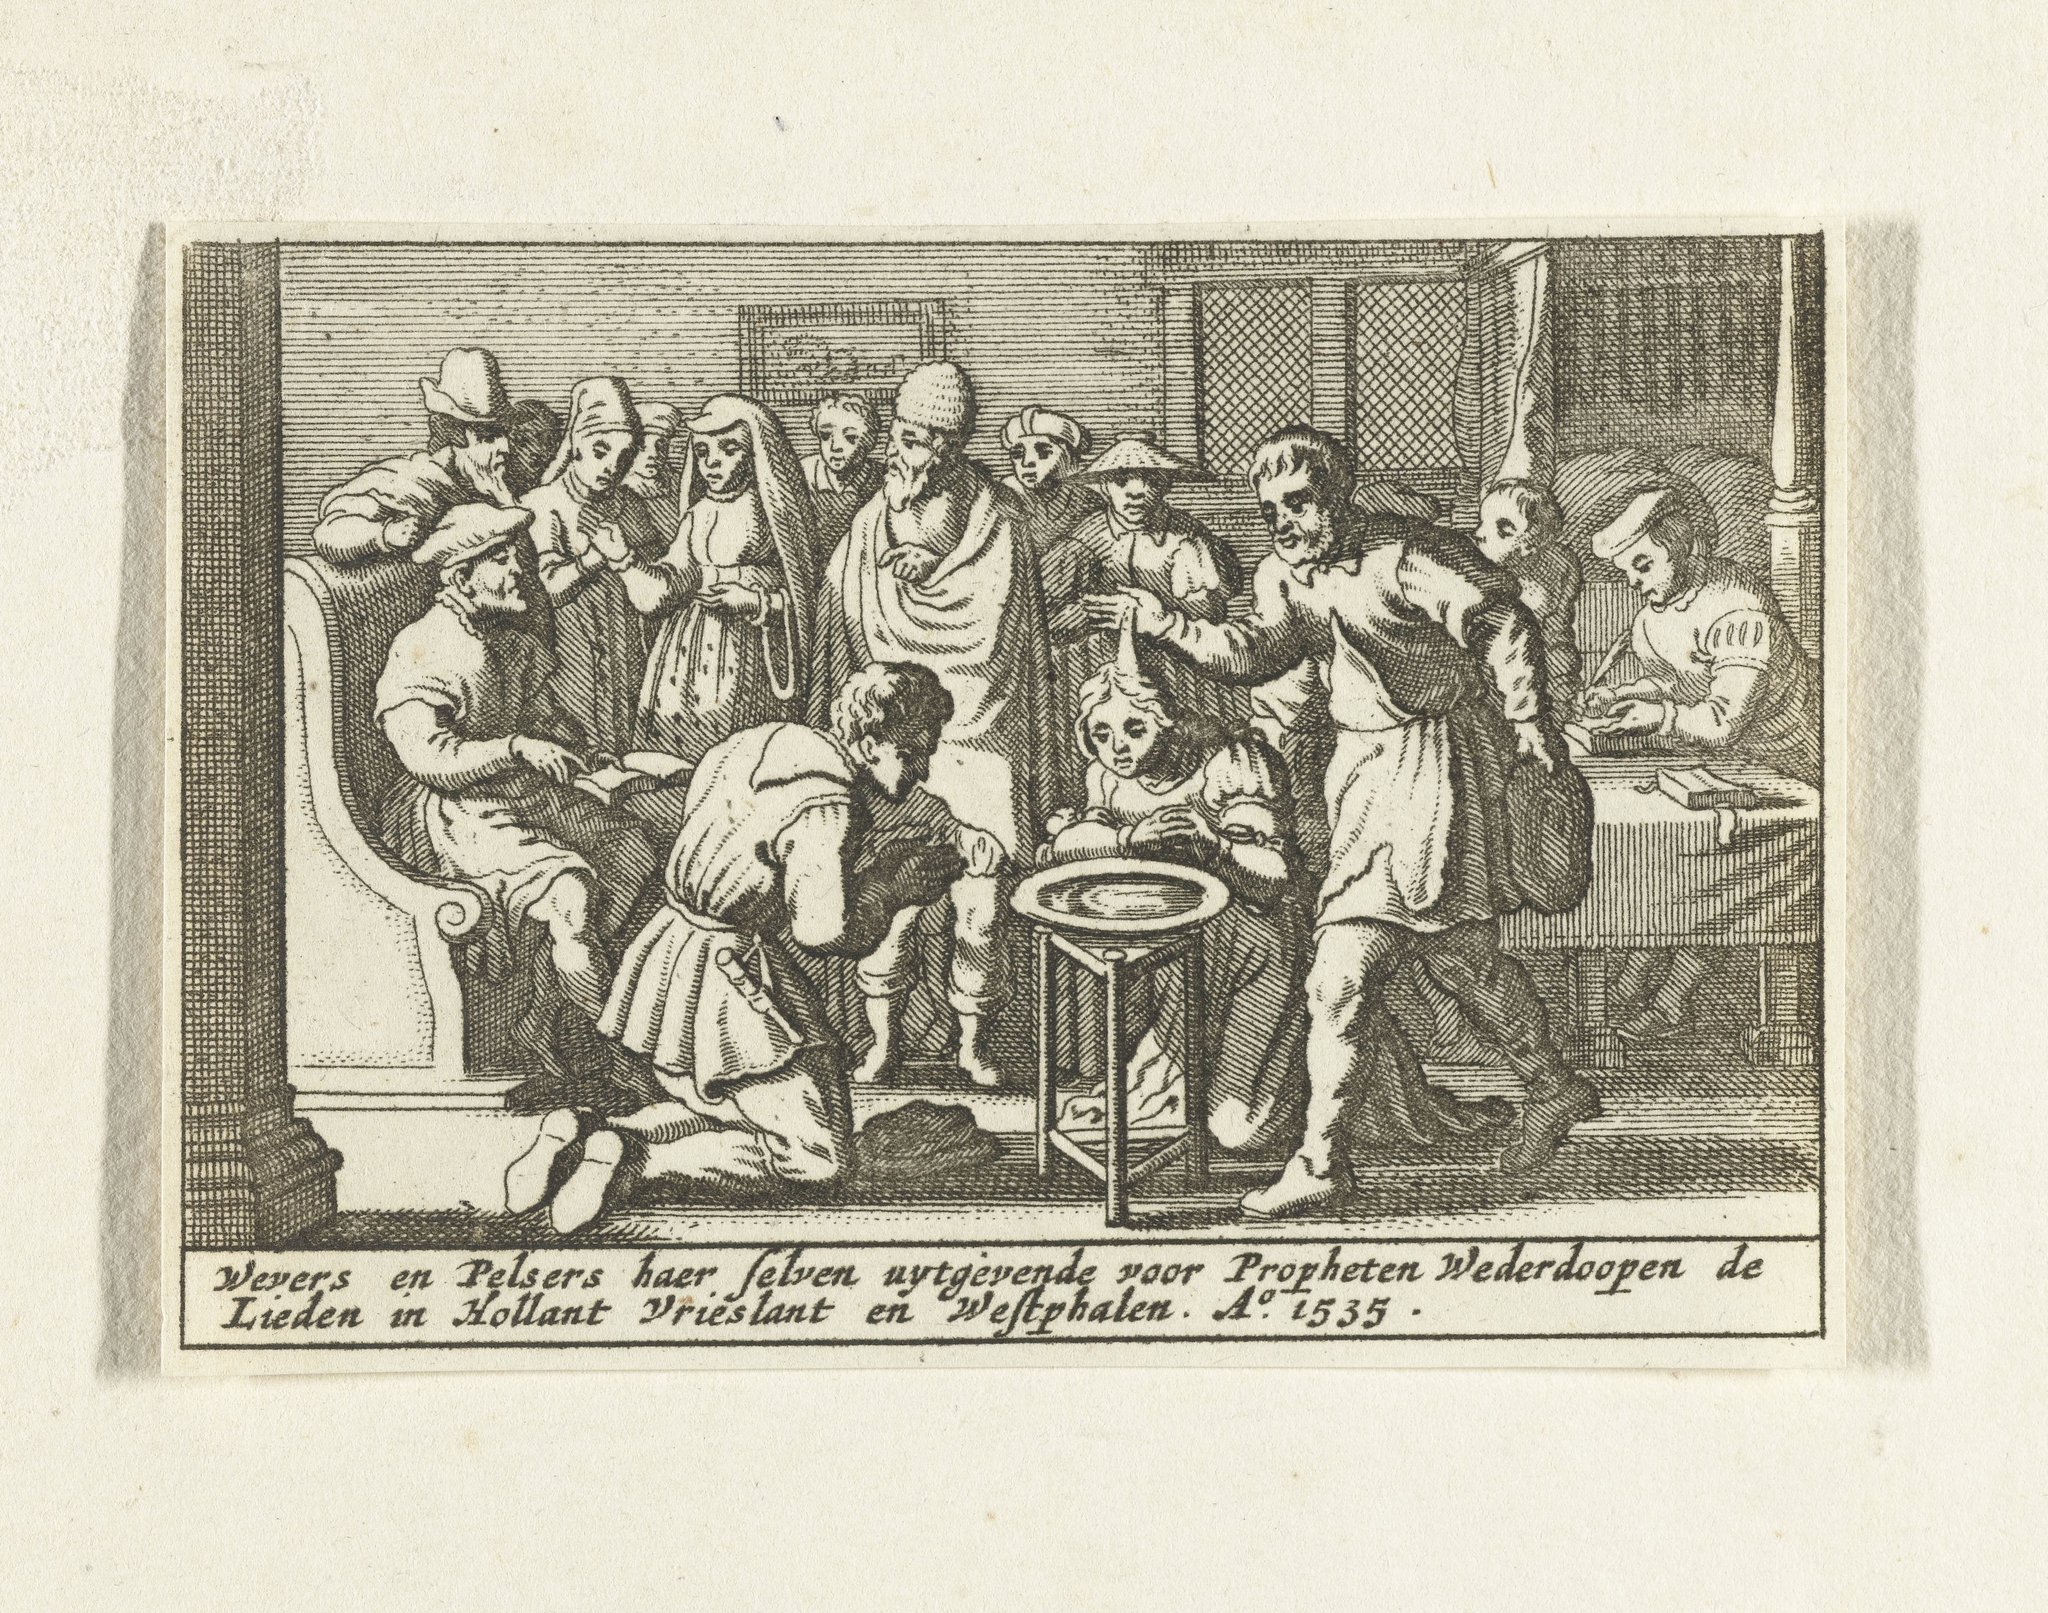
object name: print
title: Doop der wederdopers, 1535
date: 1629-1652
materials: paper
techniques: etching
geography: northern netherlands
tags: baptism ~ protestant service, amsterdam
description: Deze prenten zijn gebaseerd op de oorspronkelijke anonieme gravures in de eerste uitgave L. Hortensius, Van den oproer der weder-dooperen, 1614. Alle 8 prenten op op één blad geplakt. Naar het verloren gegane schilderij van Barend Dircksz. in het oude stadhuis te Amsterdam.